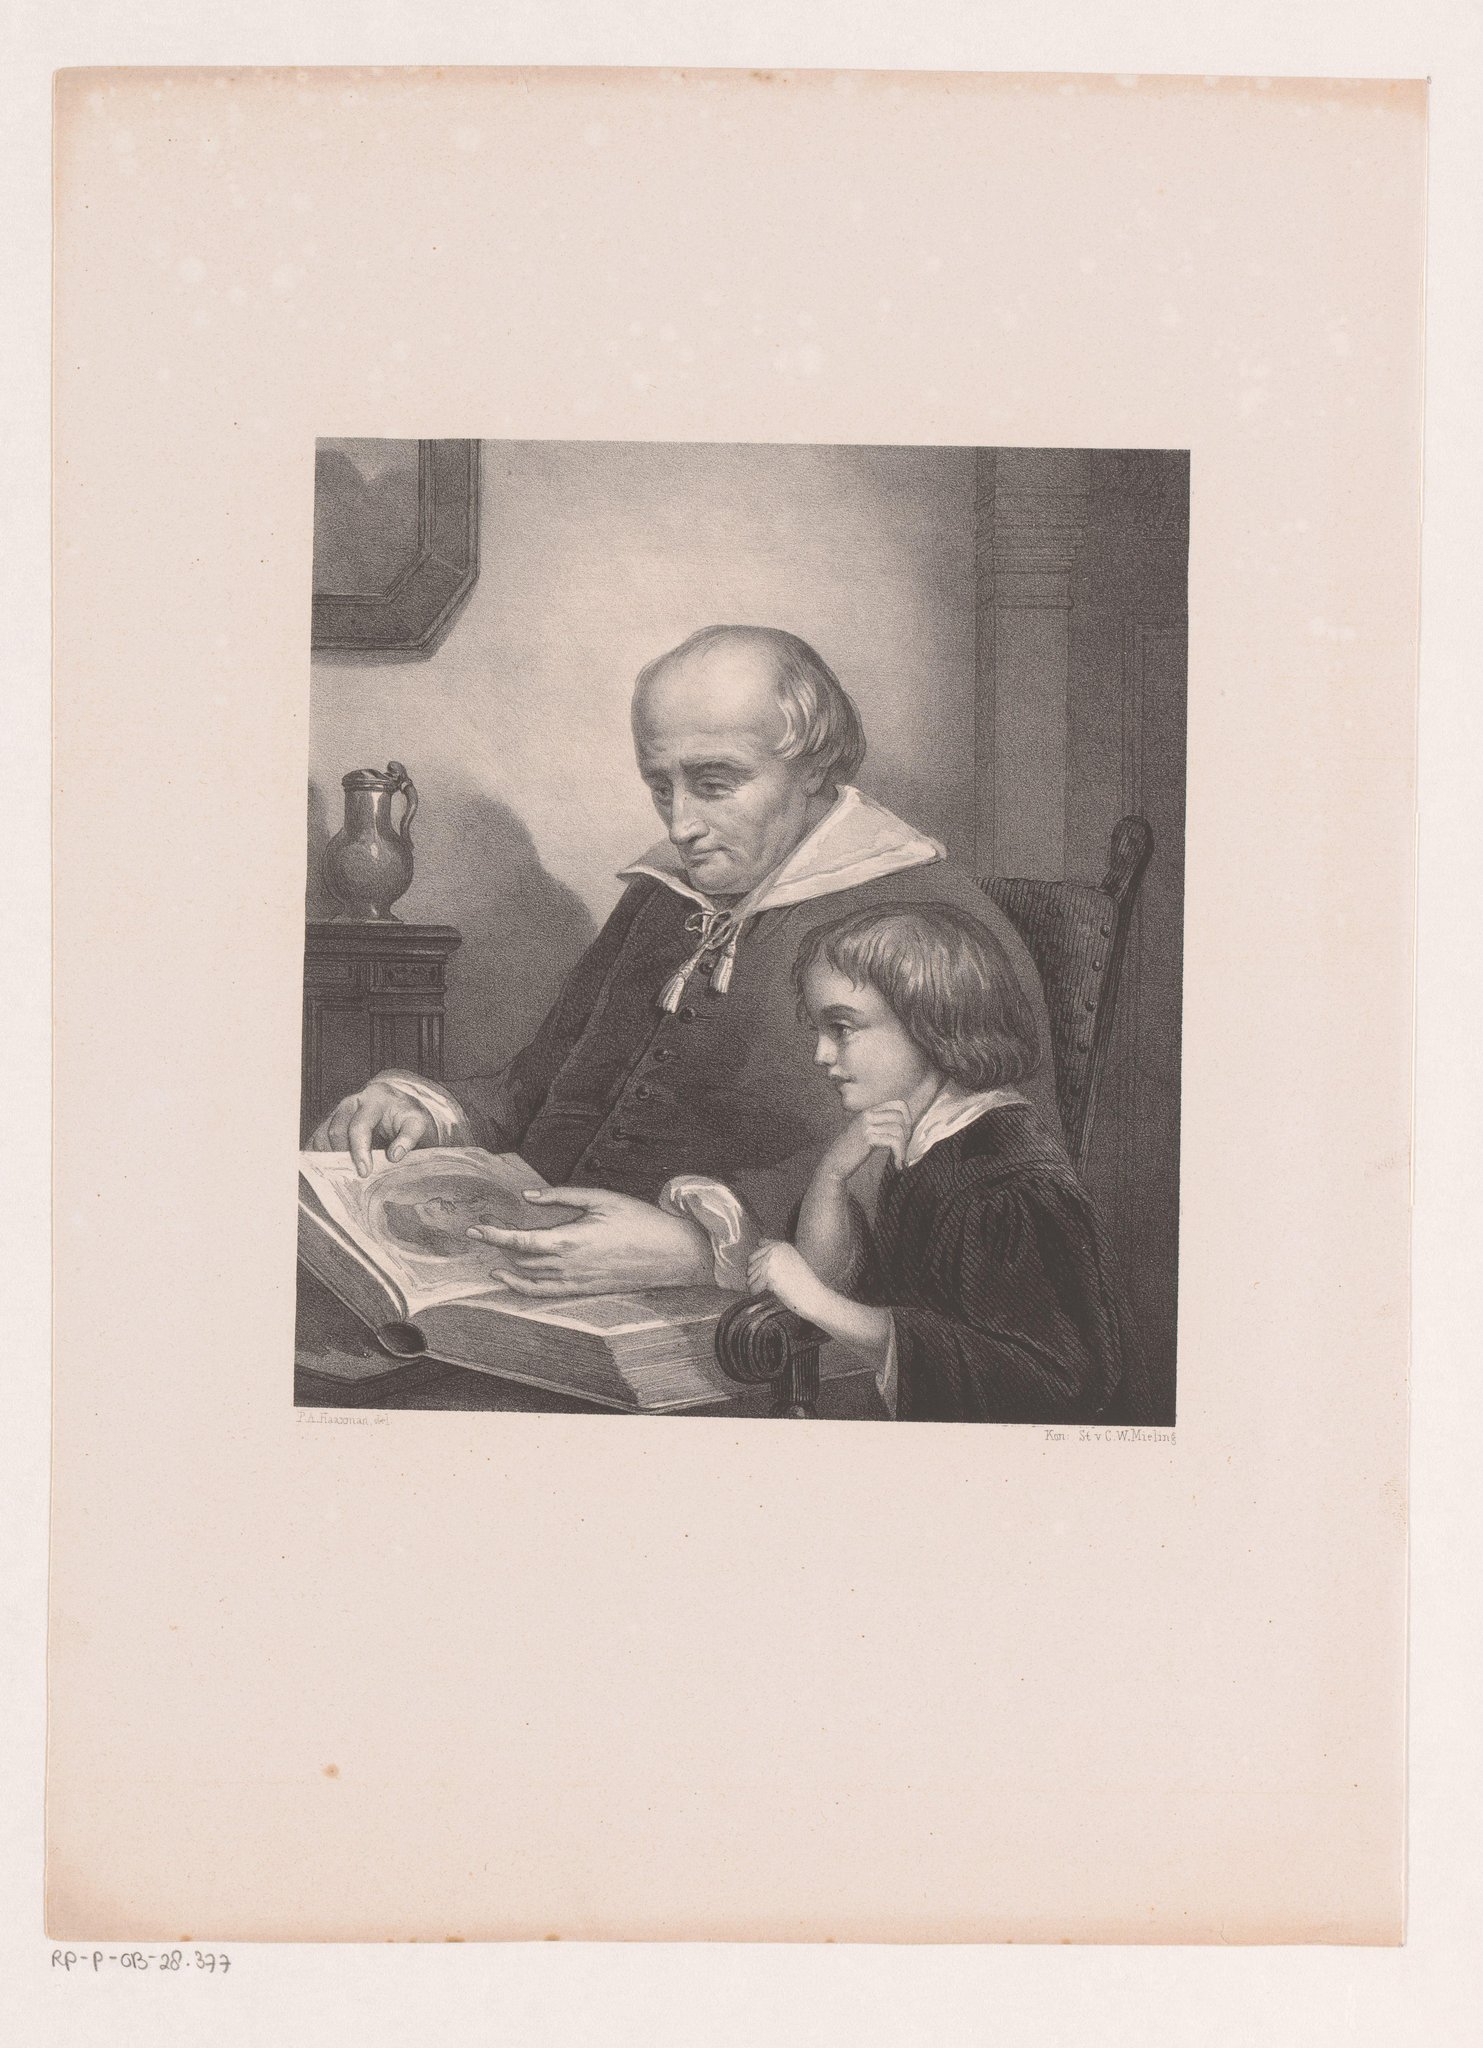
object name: print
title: Man en kind bekijken een boek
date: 1847-1863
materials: paper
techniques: lithograph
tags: boy (child between toddler and youth), reading a picture book, reading to somebody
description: De man zit in een stoel. In het boek is een afbeelding van een portret opgenomen.